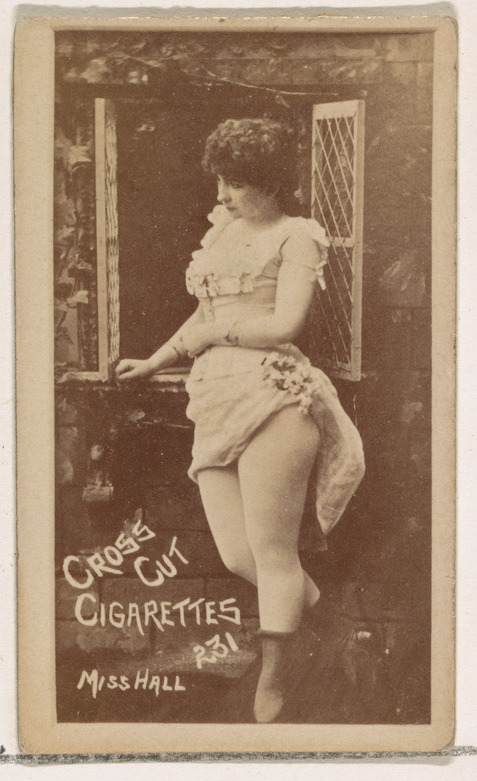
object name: print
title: Card Number 231, Miss Hall, from the Actors and Actresses series (N145-1) issued by Duke Sons & Co. to promote Cross Cut Cigarettes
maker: w. duke, sons & co.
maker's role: publisher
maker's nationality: american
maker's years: 1870-1920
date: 1880-1889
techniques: albumen silver print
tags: women,actresses